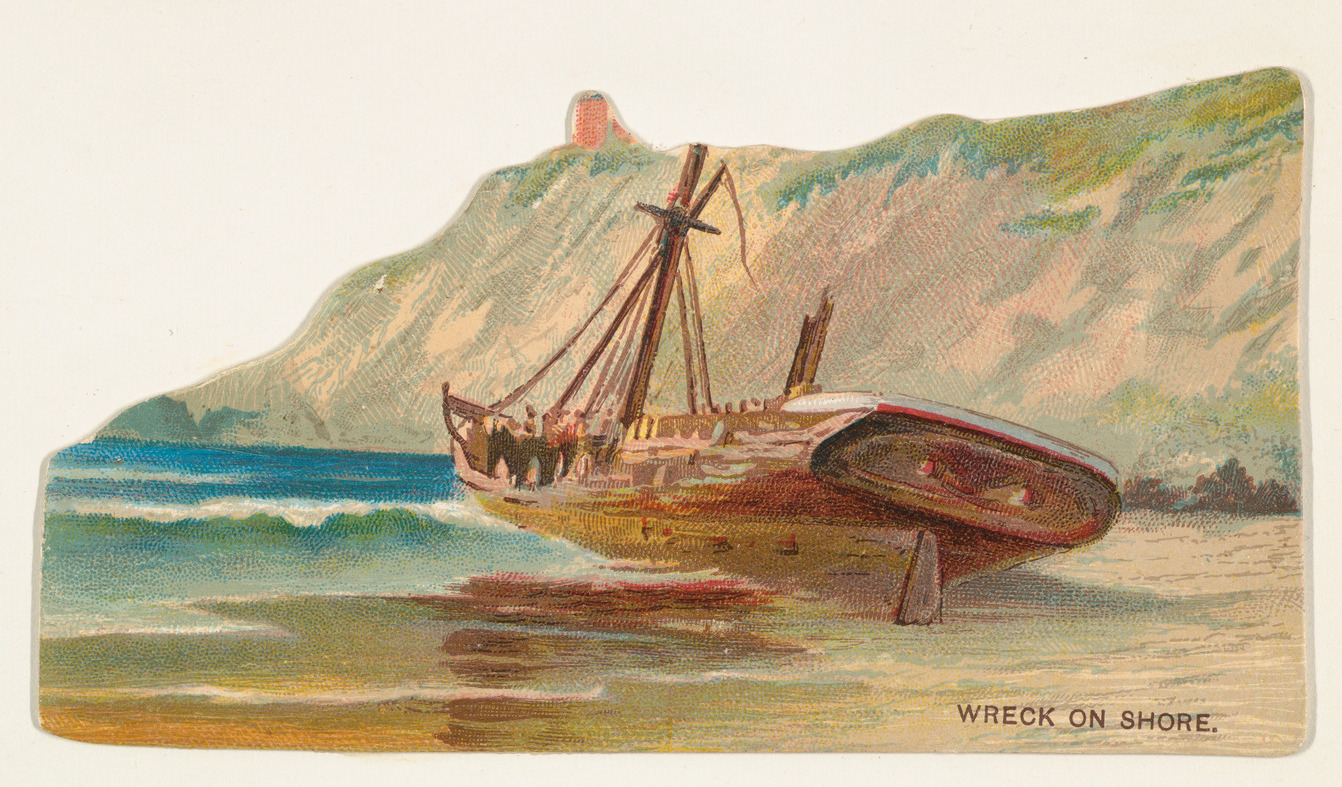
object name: print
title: Wreck on Shore, from the Types of Vessels series (N139) issued by Duke Sons & Co. to promote Honest Long Cut Tobacco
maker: w. duke, sons & co.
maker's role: publisher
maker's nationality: american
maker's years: 1870-1920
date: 1889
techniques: color lithograph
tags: shipwrecks,seas,ships